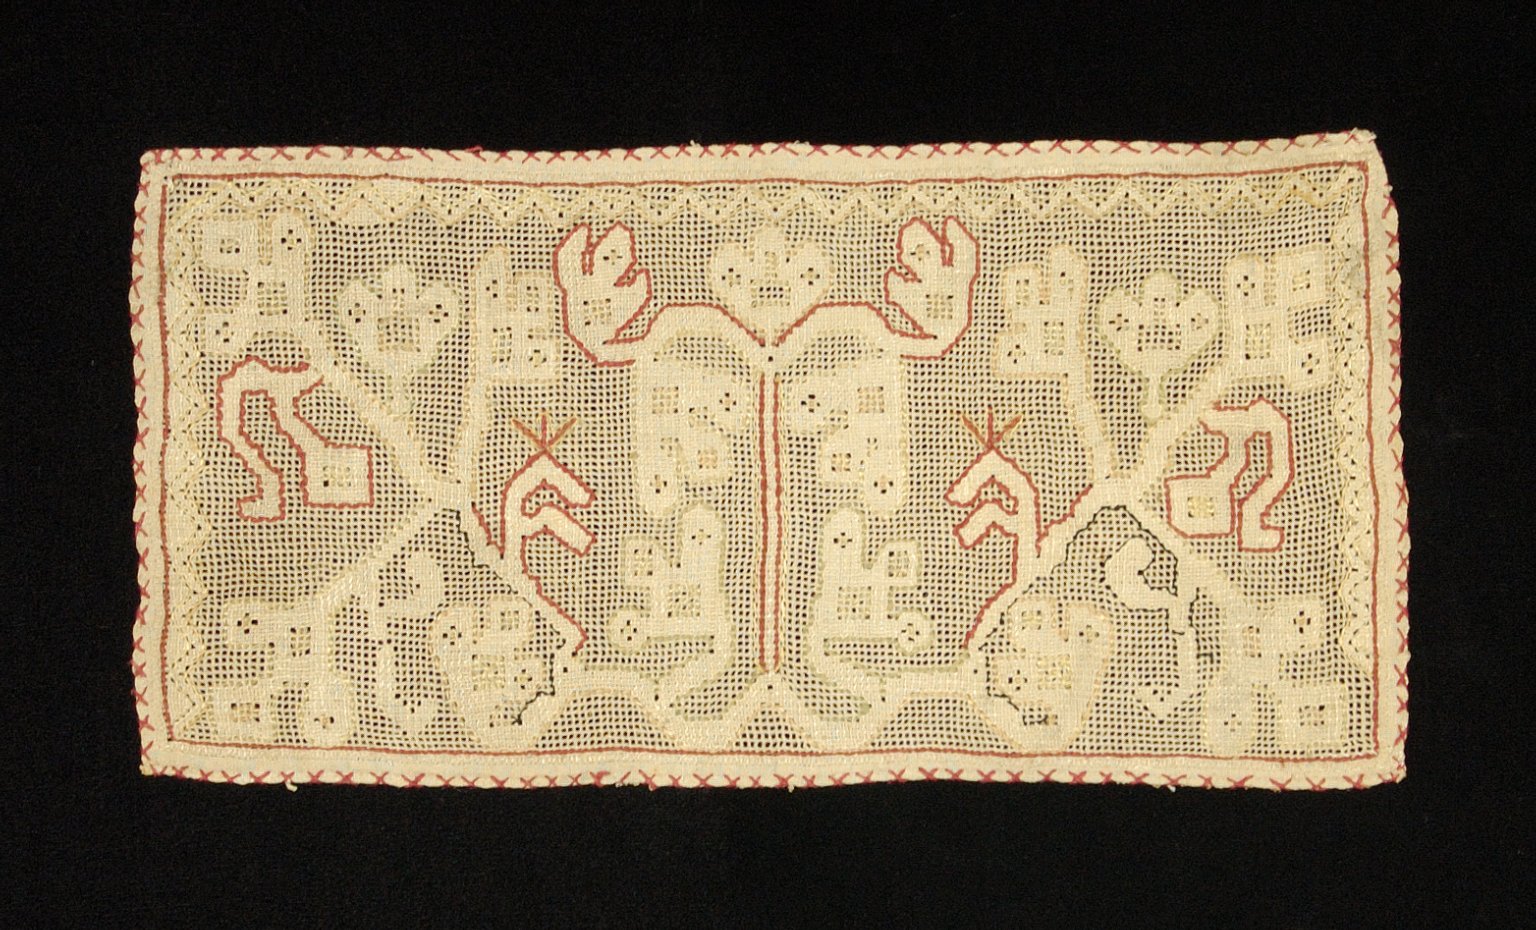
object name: border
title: Towle border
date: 1800-1850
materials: linen, silk